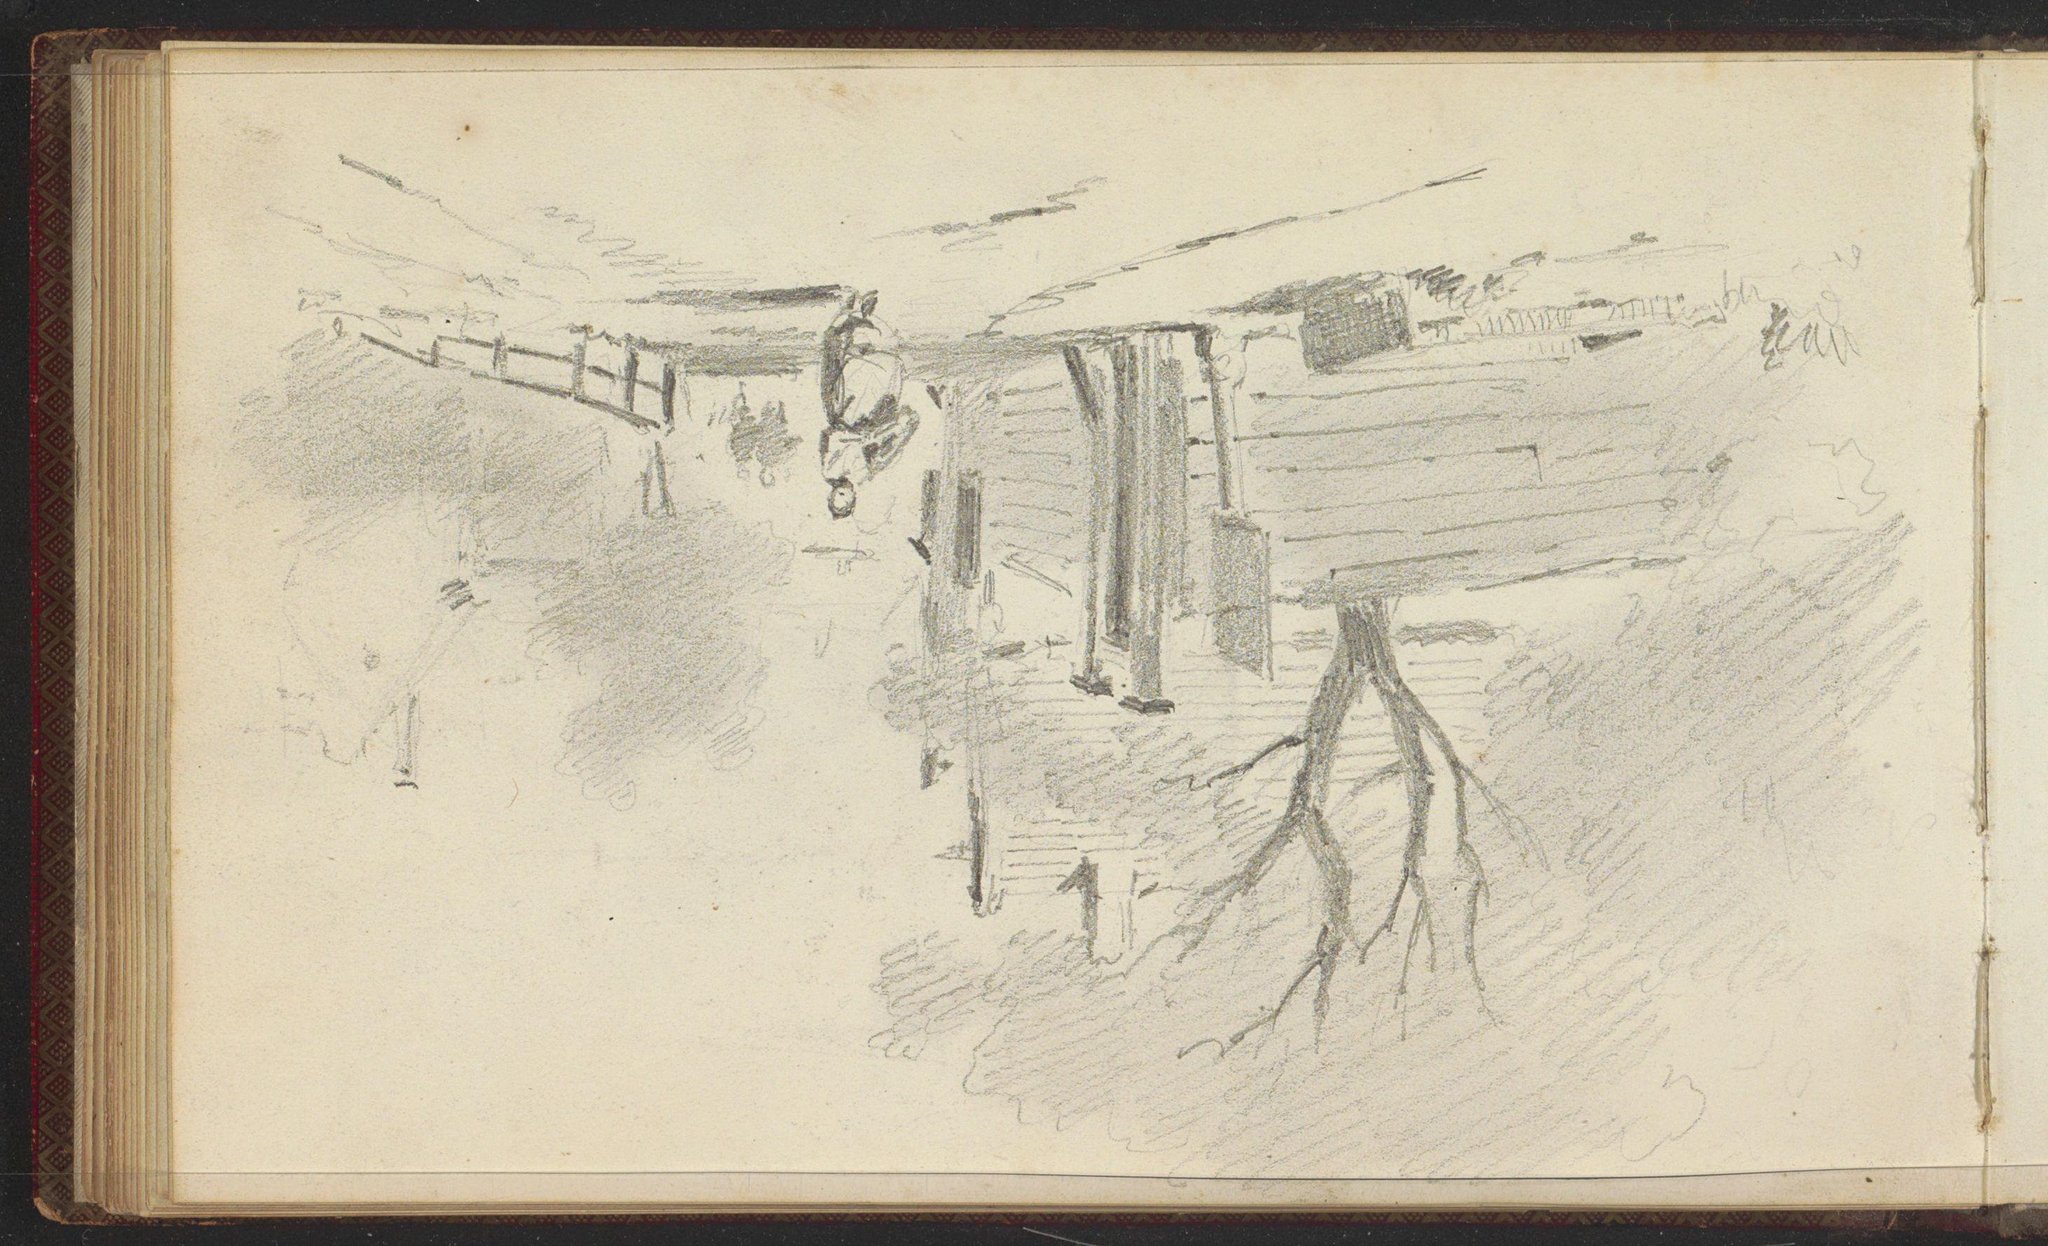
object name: sketchbook leaf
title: Gezicht op een straat met figuren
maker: adrianus eversen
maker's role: draughtsman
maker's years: 1818-1897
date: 1828-1897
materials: paper, pencil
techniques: stumping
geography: netherlands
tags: adult woman, road, path, architecture, civic architecture; edifices; dwellings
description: Langs een weg staan gebouwen. Op de weg lopen figuren. Ook een hek. Blad 50 verso uit een schetsboek met 52 bladen vervaardigd in de omgeving van Kampen, Hattem, Hoorn en Zwolle.